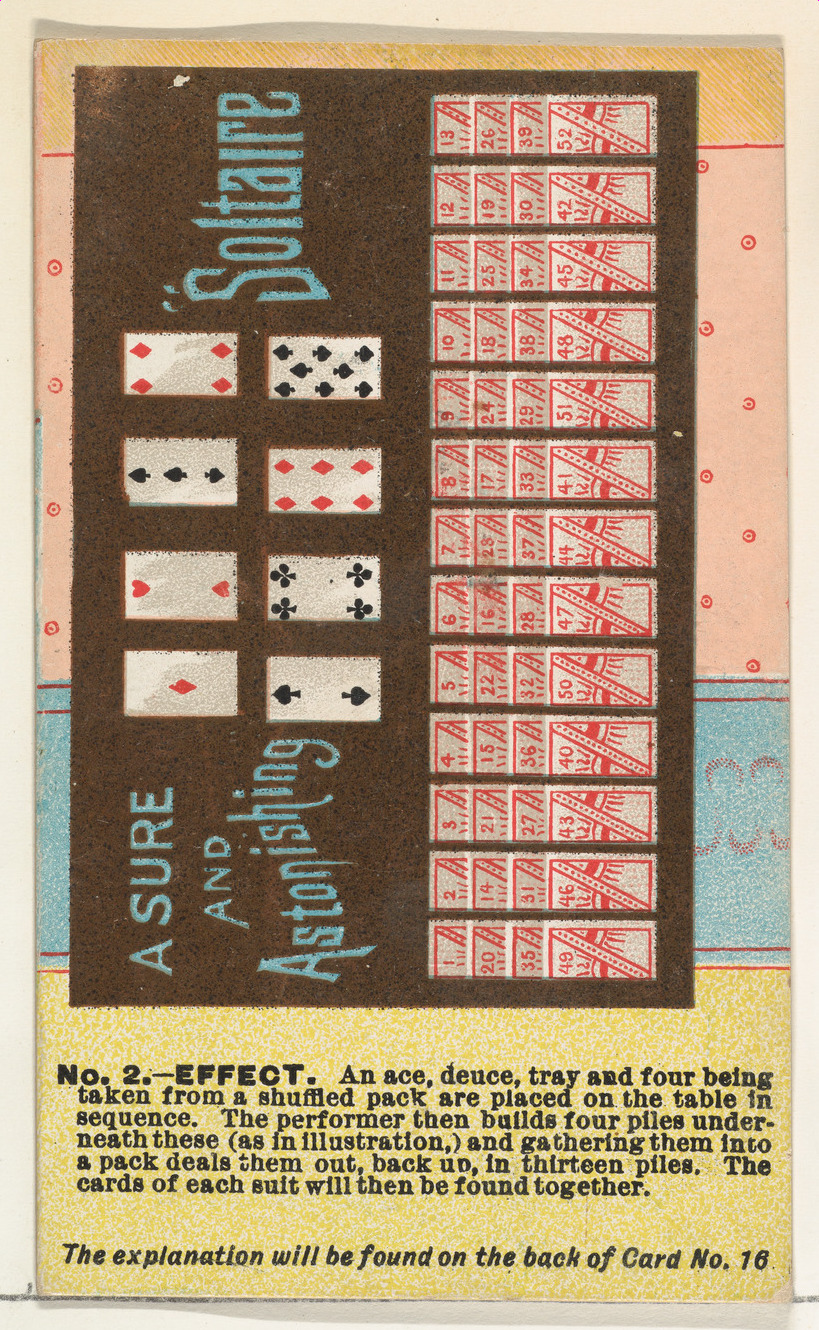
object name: print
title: Number 2, A Sure and Astonishing Soltaire, from the Tricks with Cards series (N138) issued by W. Duke, Sons & Co. to promote Honest Long Cut Tobacco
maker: w. duke, sons & co.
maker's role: publisher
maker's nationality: american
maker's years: 1870-1920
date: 1887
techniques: color lithograph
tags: playing cards